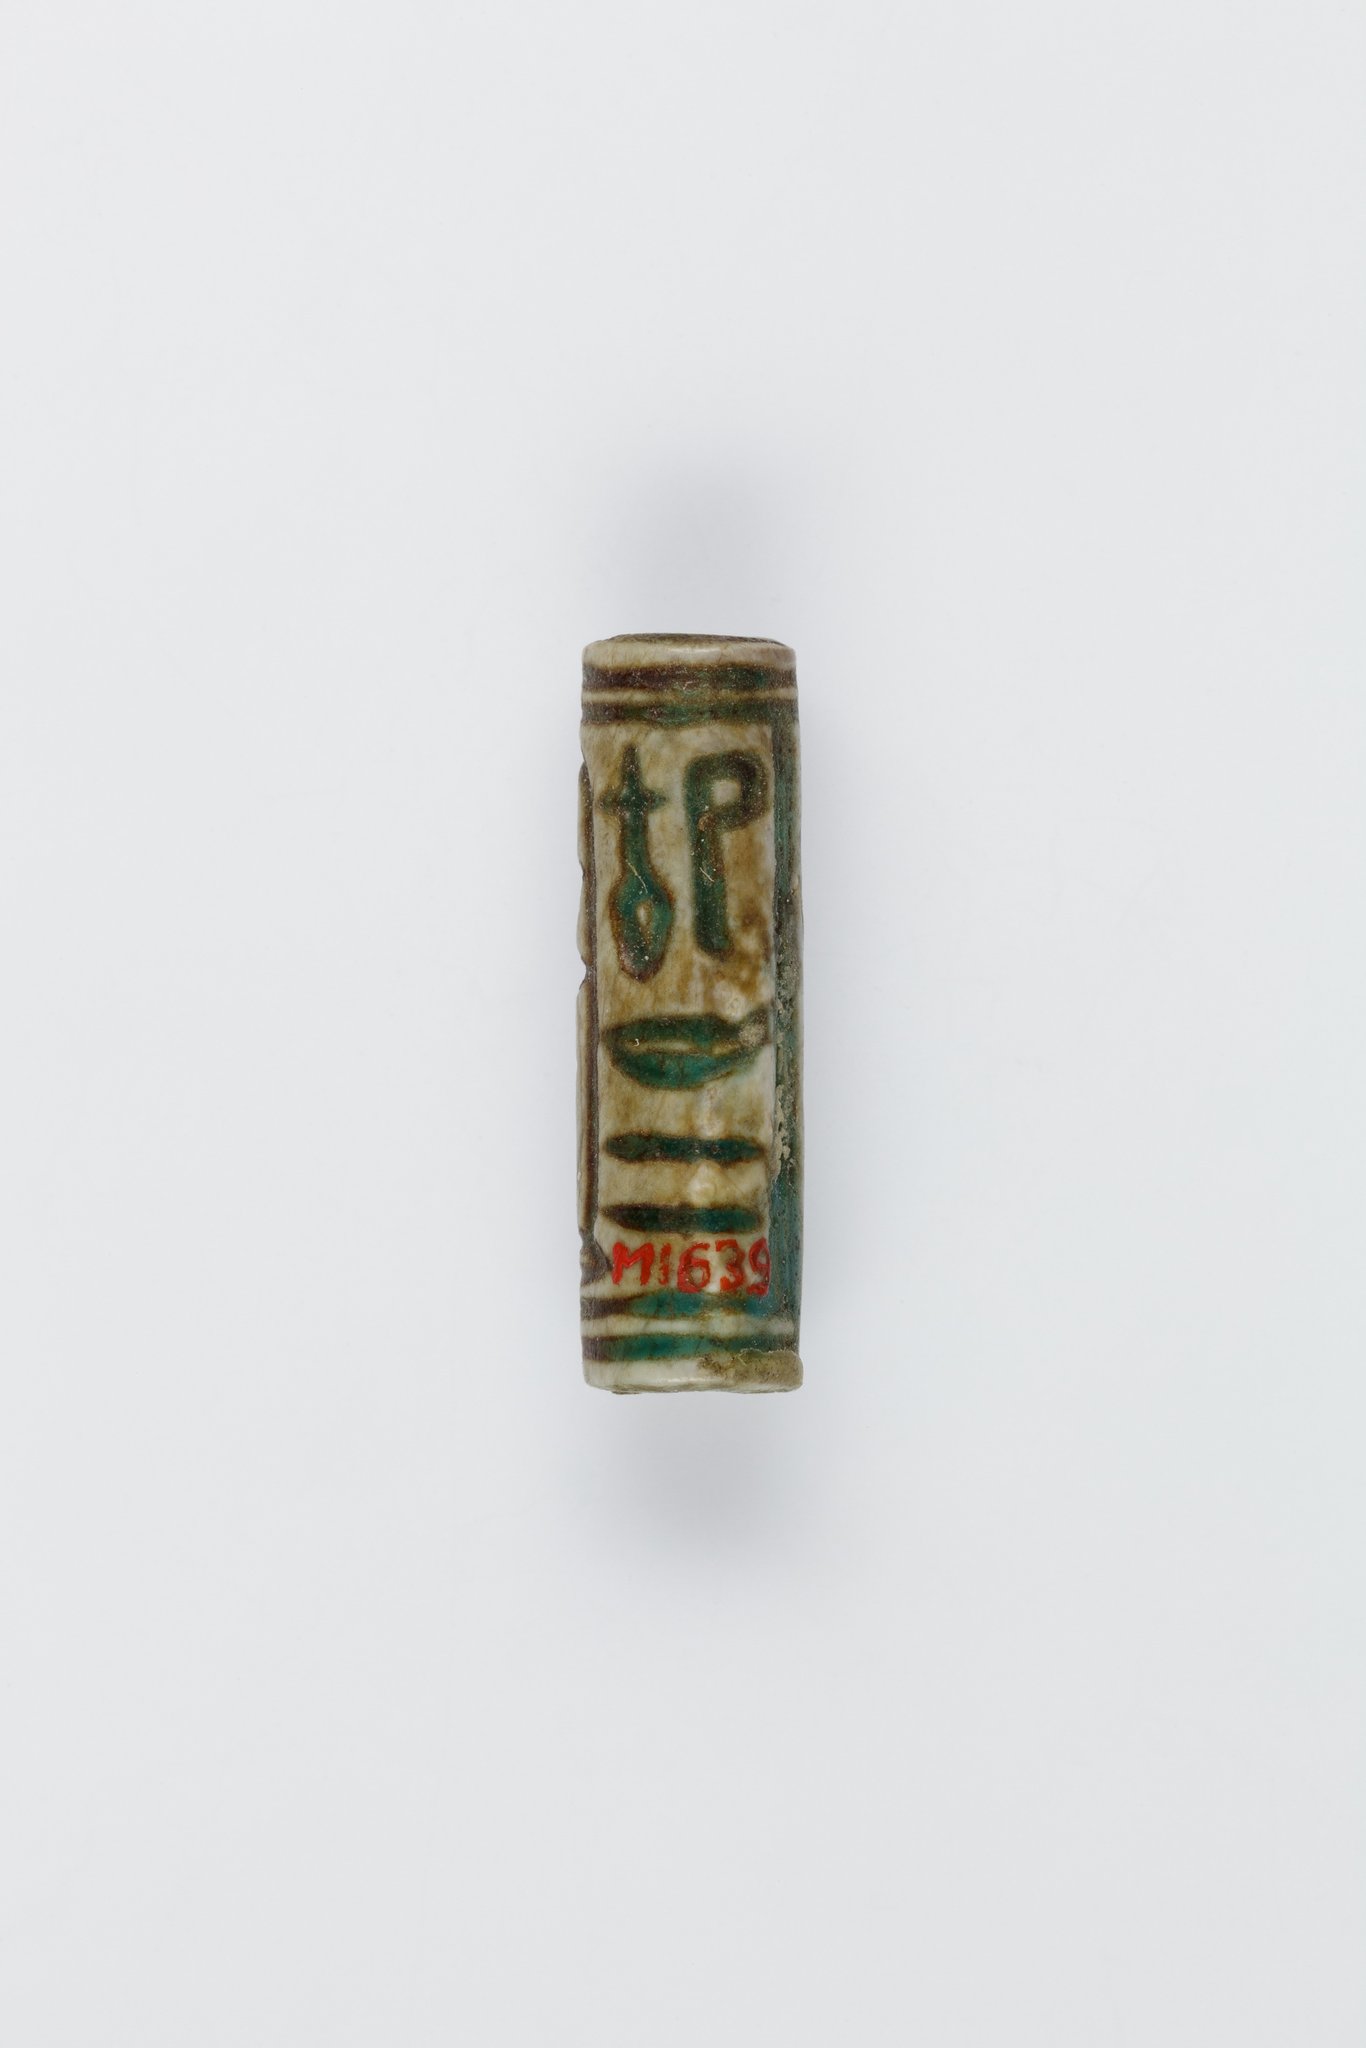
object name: cylinder seal, merneferre aya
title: Cylinder Seal of King Merneferre Aya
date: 1700-1676 BCE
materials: stone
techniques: glazing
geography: egypt